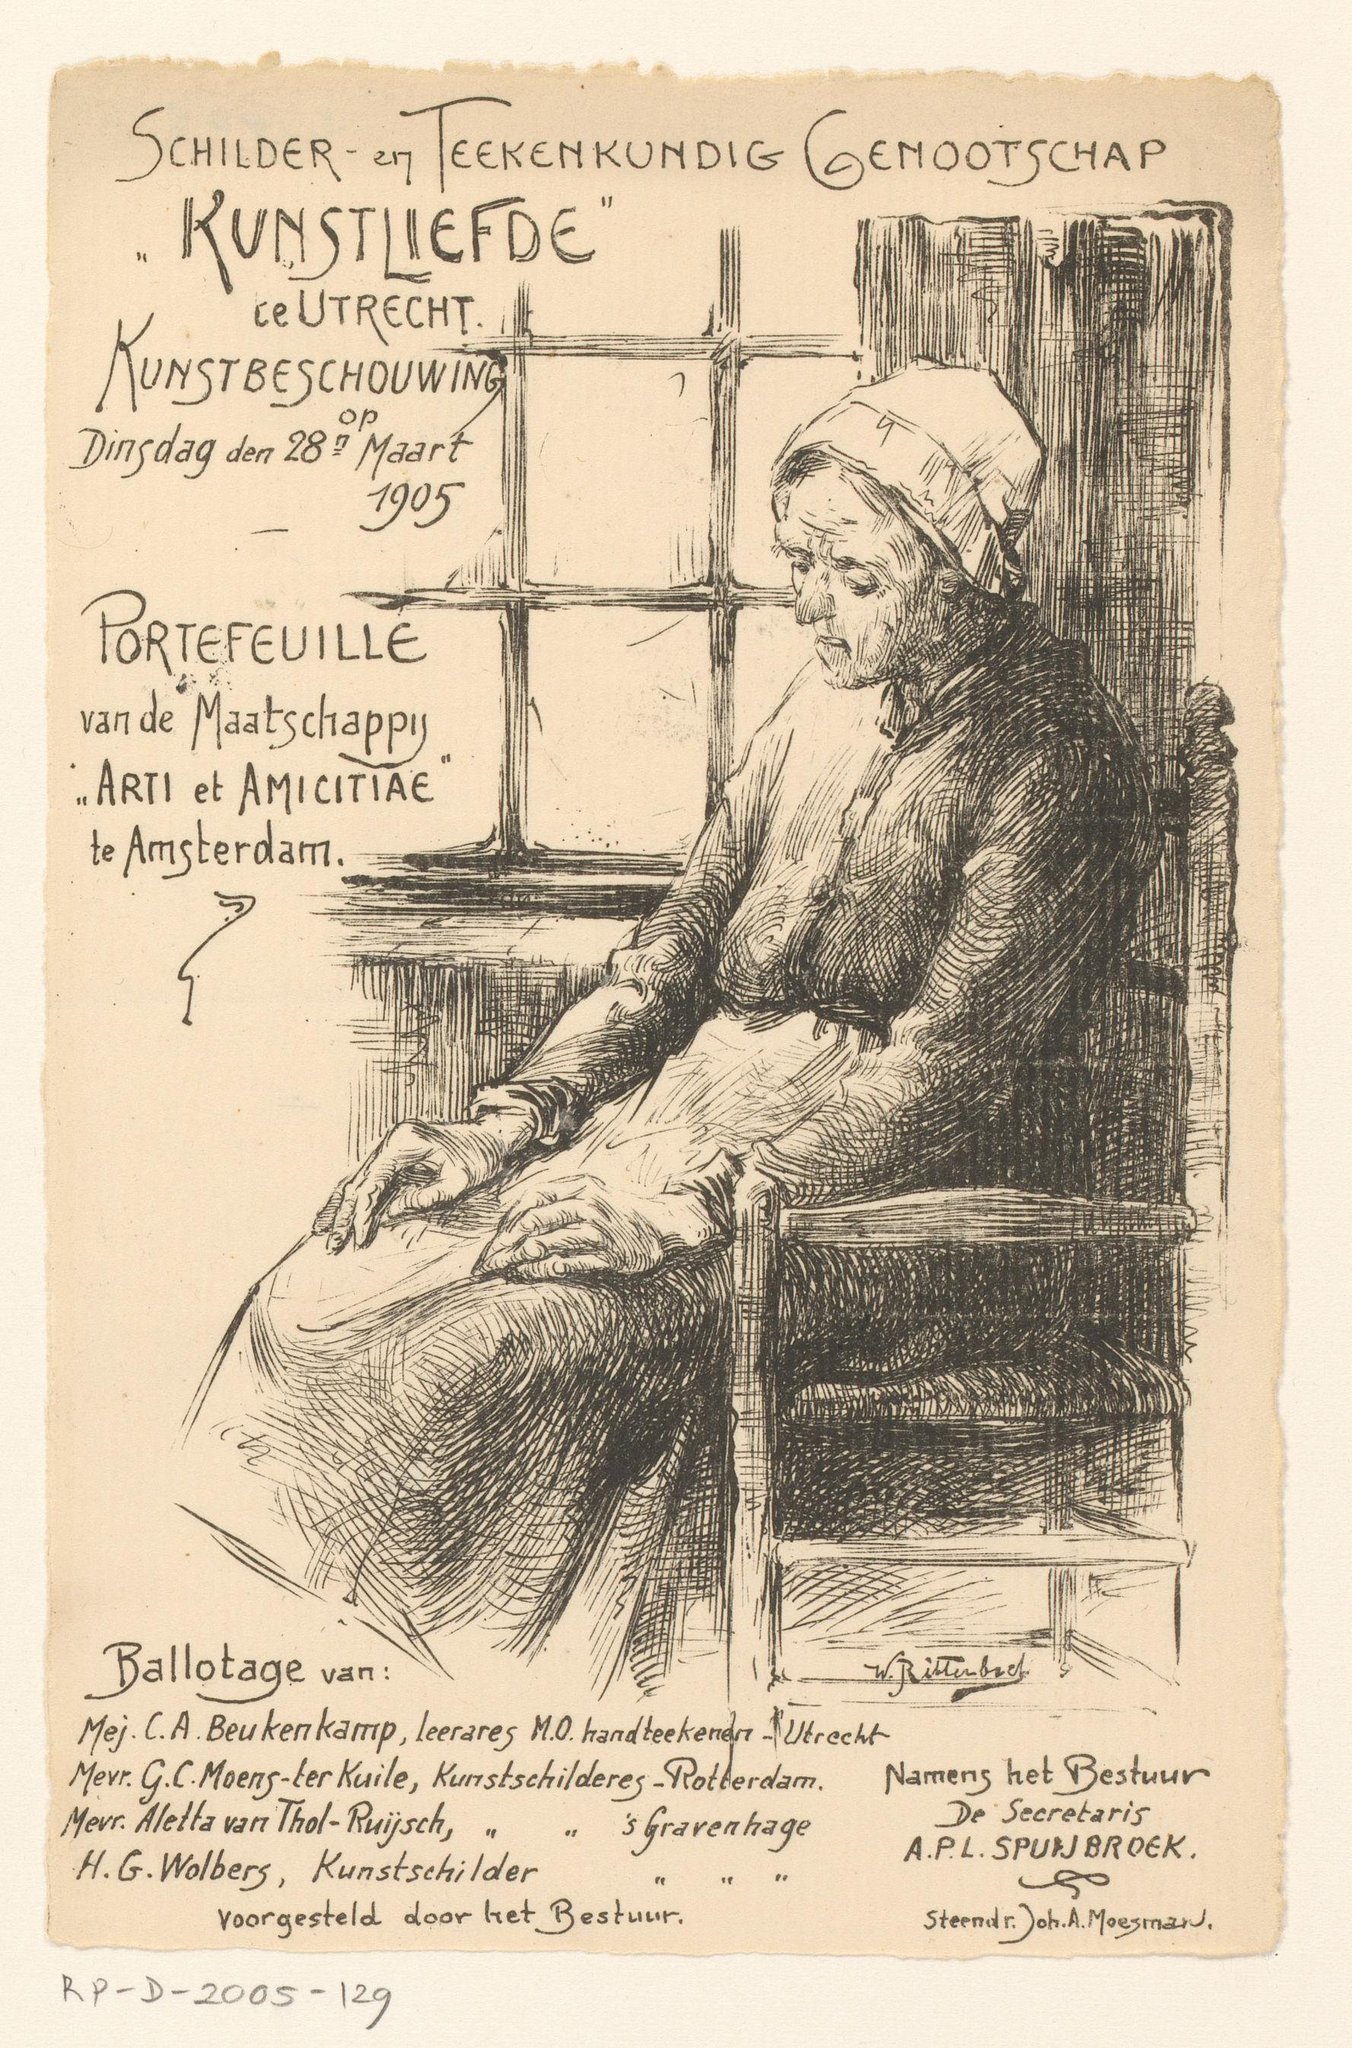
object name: invitation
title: Uitnodiging van Schilder- en Teekenkundig Genootschap "Kunstliefde" voor een kunstbeschouwing, 28 maart 1905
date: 1903-1905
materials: paper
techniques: lithograph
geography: utrecht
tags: criticizing and discussing art, art criticism, circle, club of artists, collecting and exhibiting products of the fine arts, old woman, chair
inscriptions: collector's mark: Lugt 2228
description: Oude vrouw zittend in een stoel. Uitnodiging van Schilder- en Teekenkundig Genootschap "Kunstliefde" voor een kunstbeschouwing op 28 maart 1905 van de portefeuille van de Maatschappij Arti et Amicitiae te Amsterdam.